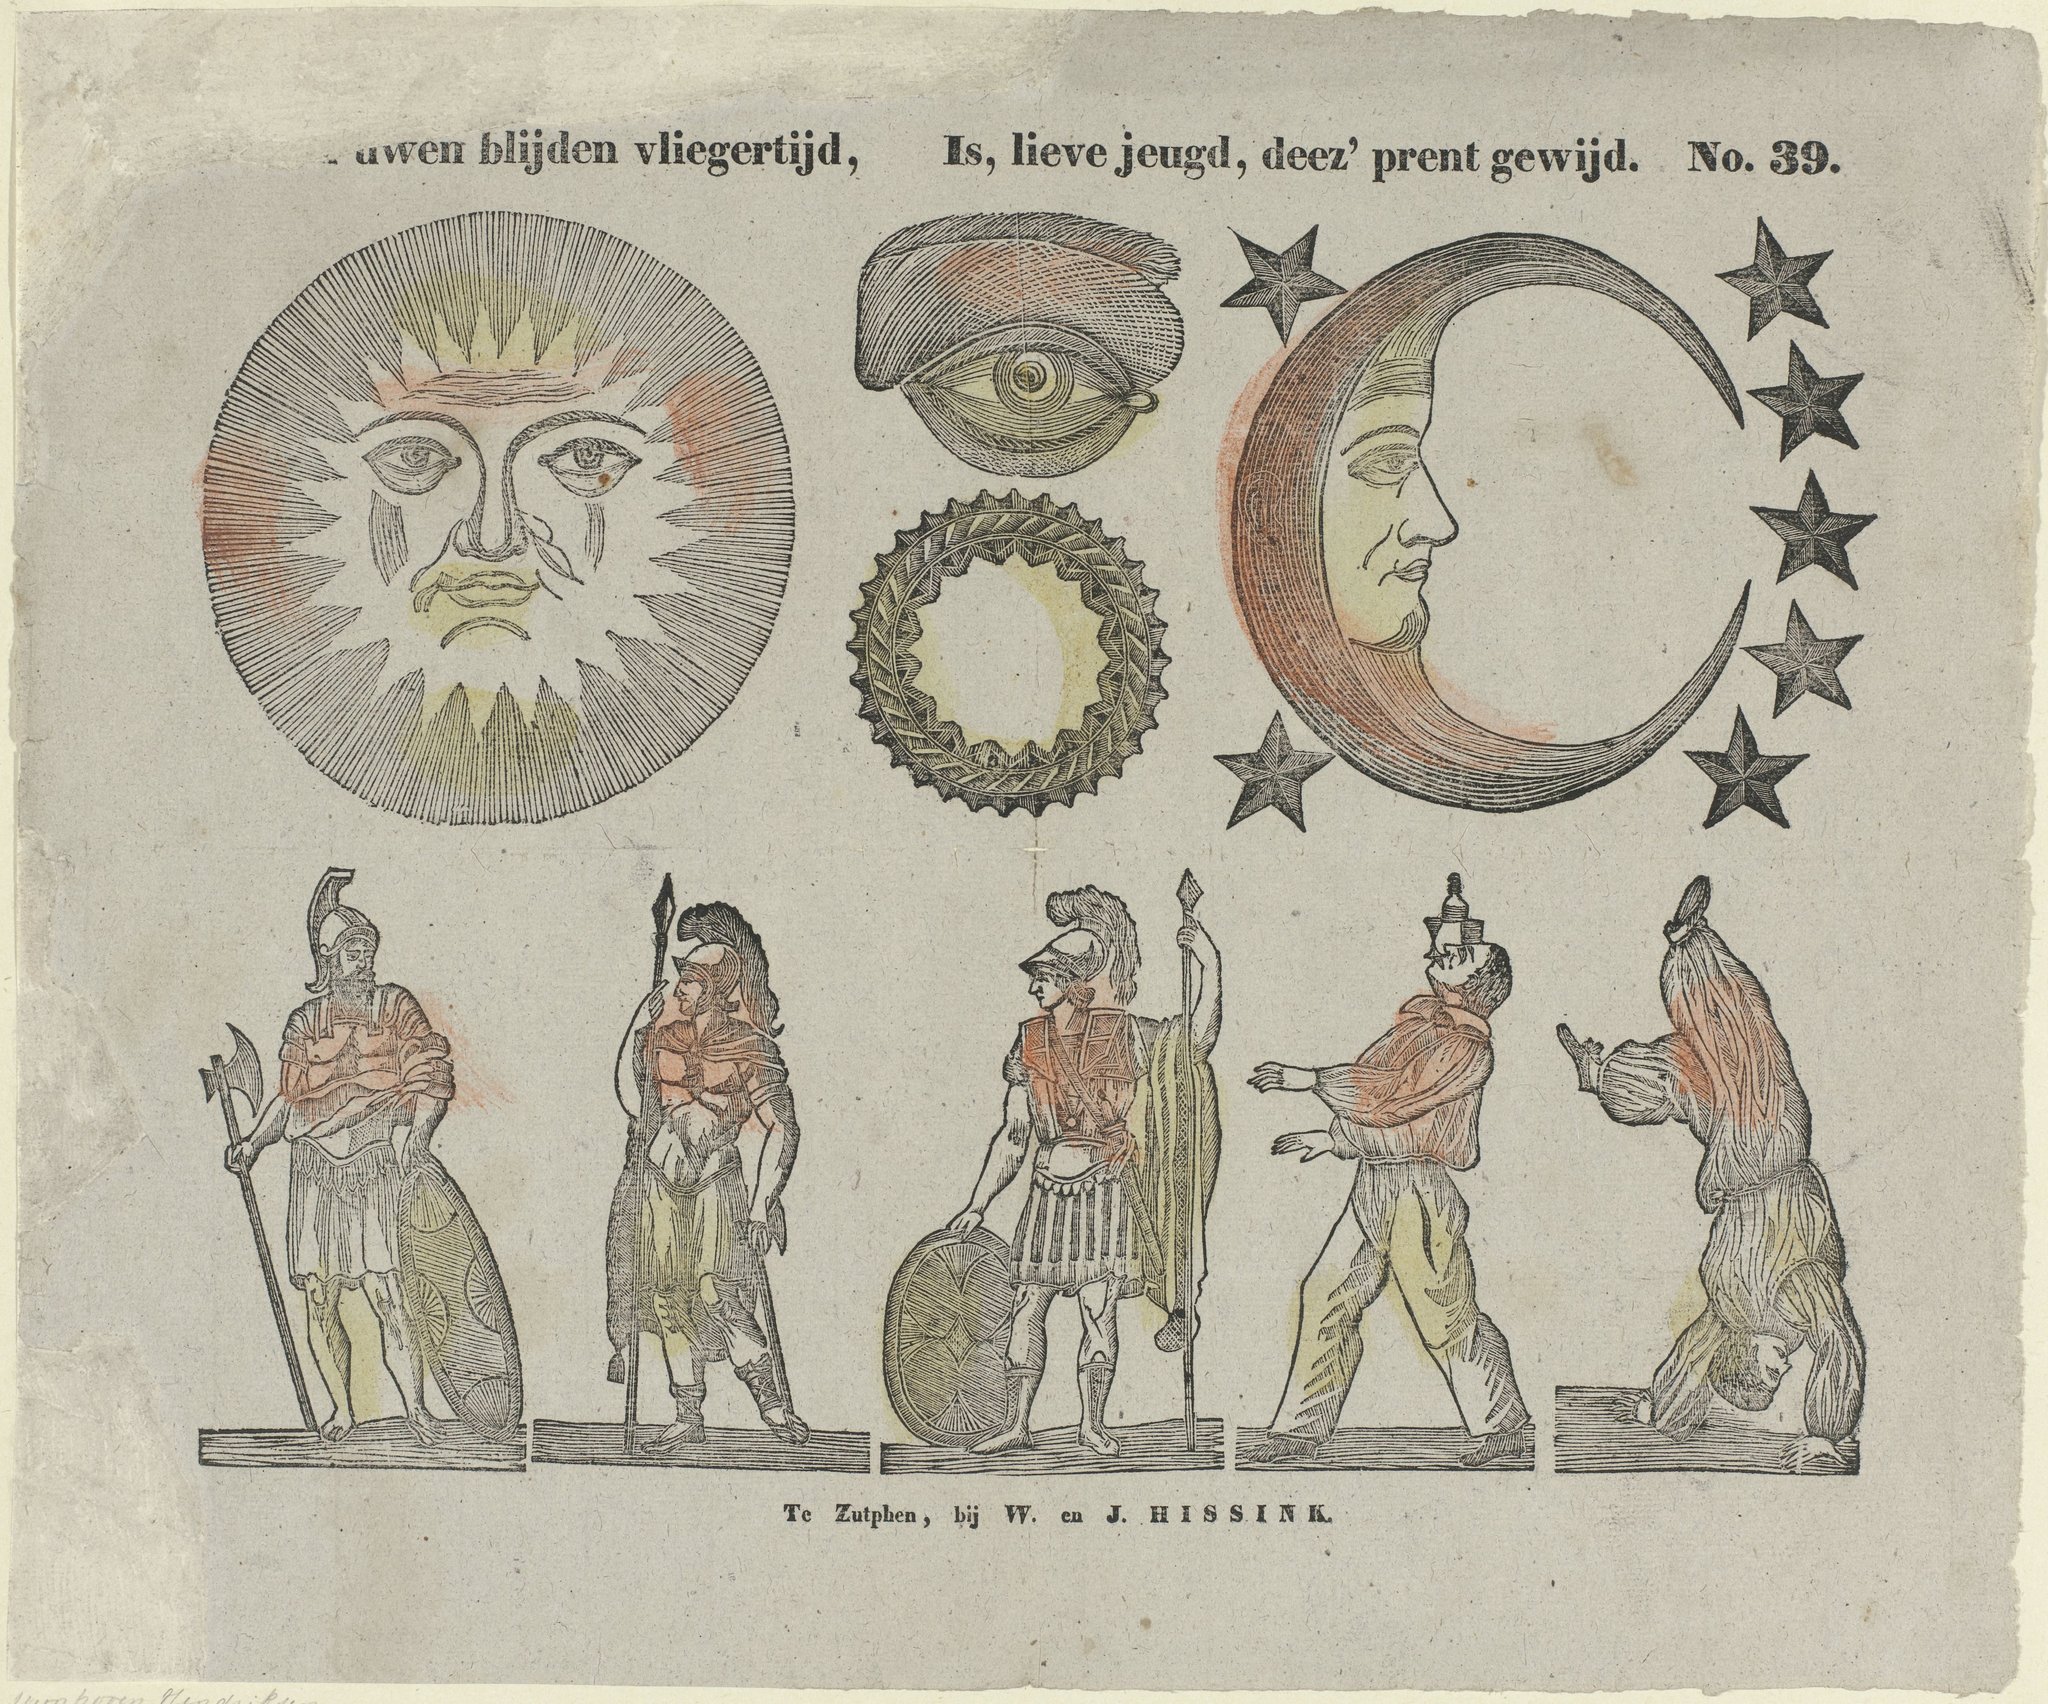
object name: print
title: Aan uwen blijden vliegertijd, / Is, lieve jeugd, deez' prent gewijd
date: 1832-1850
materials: paper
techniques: colour, letterpress printing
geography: rotterdam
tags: waxing moon represented as face, sun represented as face, wheel, etc., the soldier; the soldier's life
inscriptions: collector's mark: Lugt 2760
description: Blad met 8 voorstellingen van figuren om uit te knippen en op een vlieger te plakken, waaronder de zon, de maan en Romeinse soldaten. Genummerd rechtsboven: No. 39.